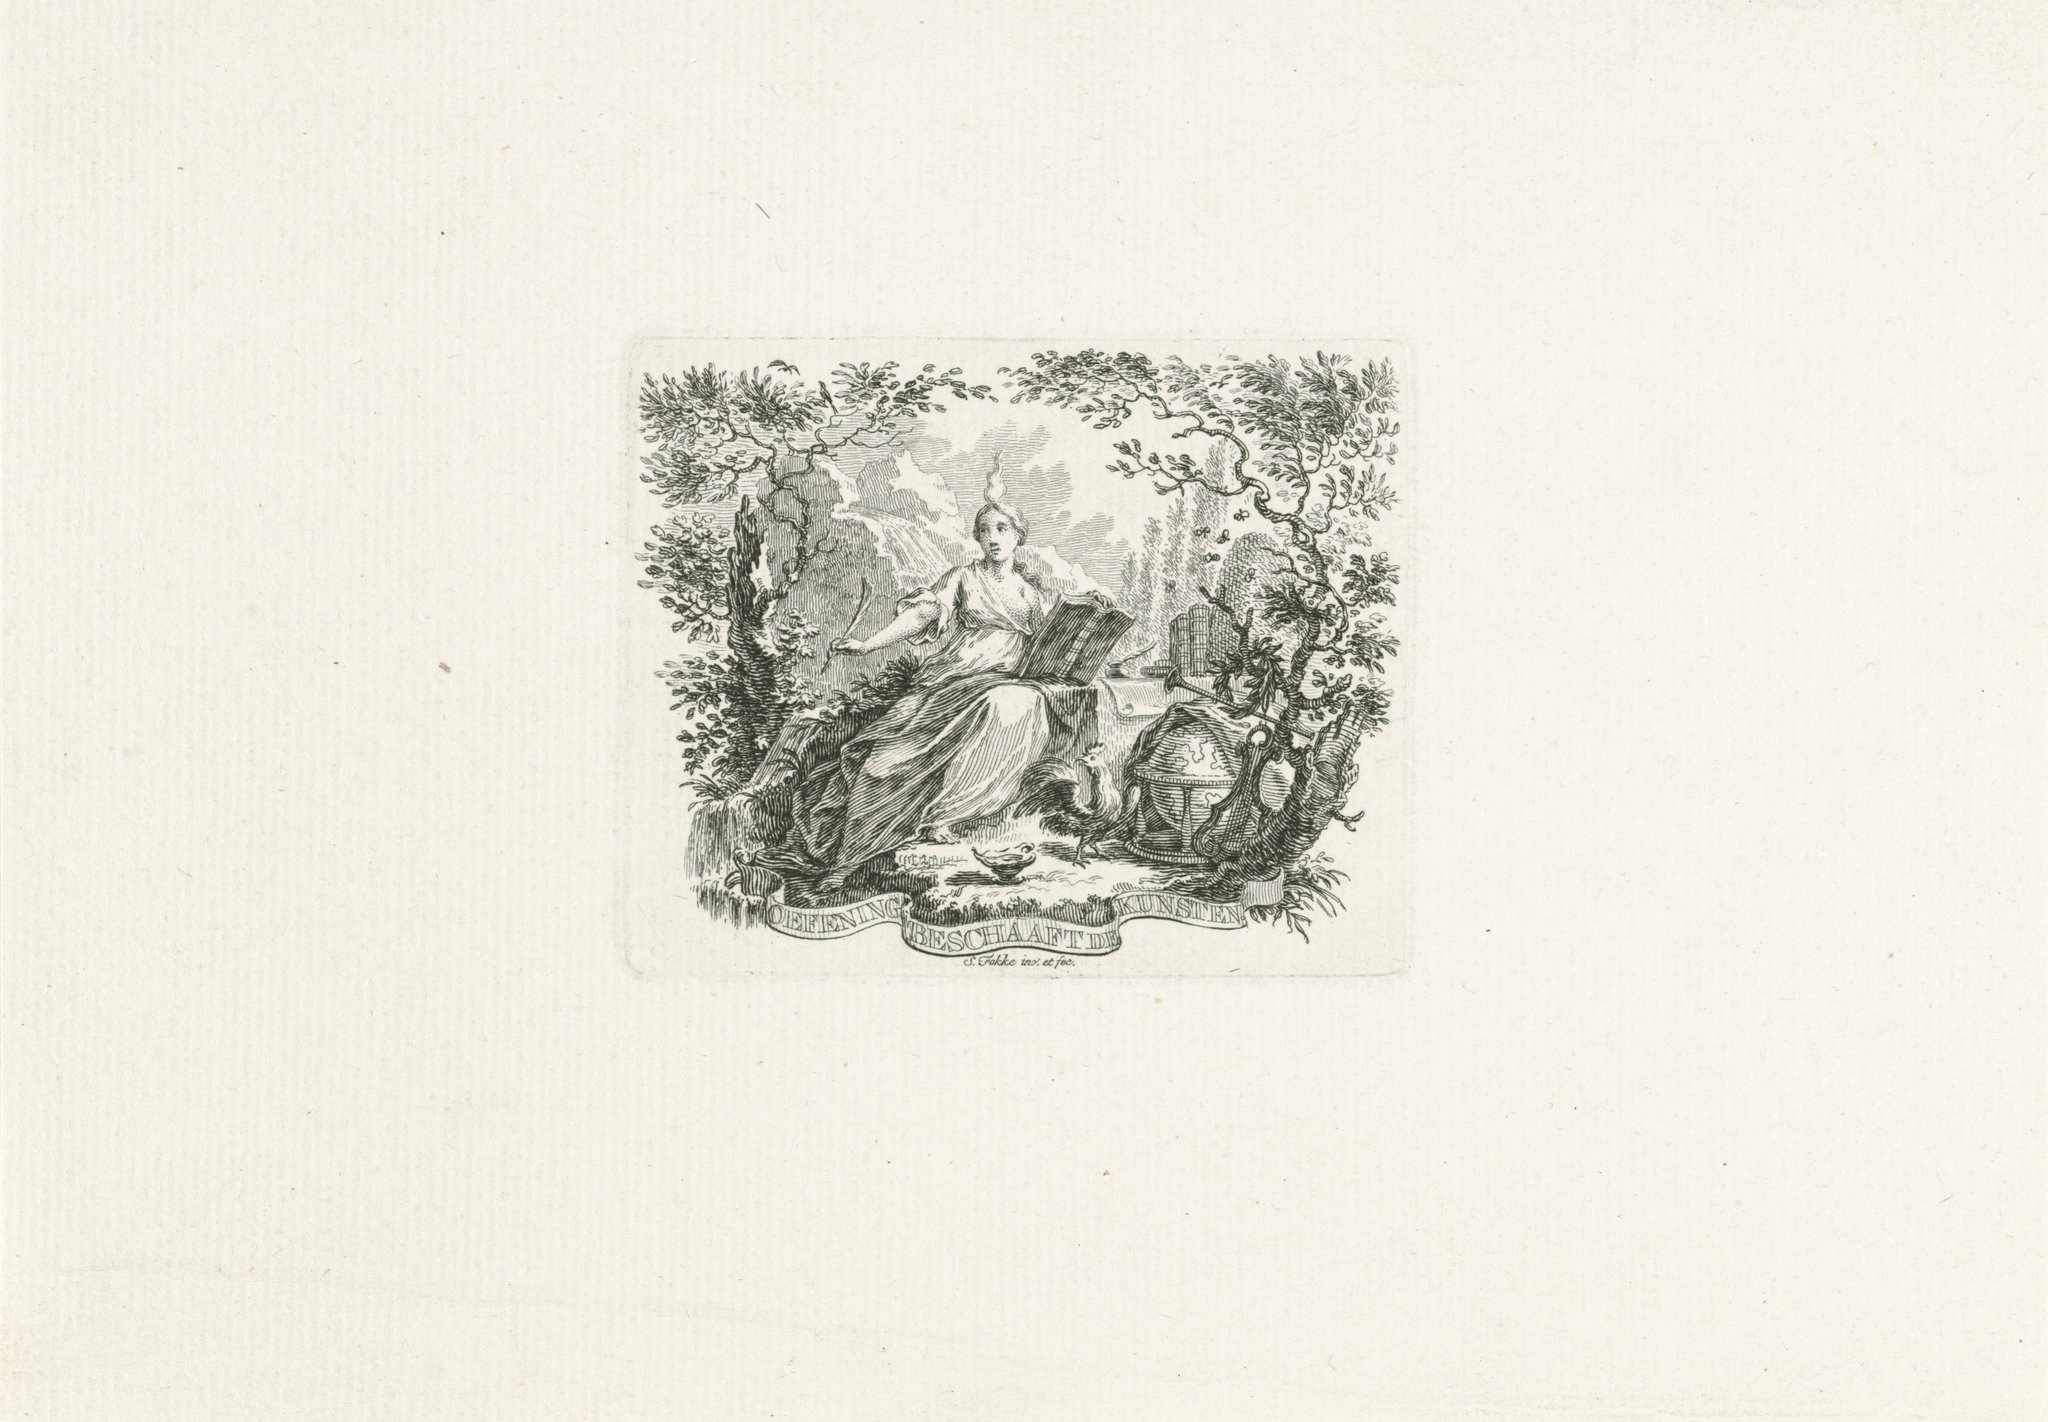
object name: print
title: Vignet van het kunstgenootschap Oefening Beschaaft de Kunsten, ca. 1764-1769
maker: simon fokke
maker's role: draughtsman, print maker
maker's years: 1712-1784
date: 1764-1769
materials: paper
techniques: etching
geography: northern netherlands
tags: symbolic representations, allegories and emblems ~ art; 'arte' (ripa)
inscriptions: collector's mark: Lugt 2228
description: Vignet van het kunstgenootschap Oefening Beschaaft de Kunsten, zoals gebruikt als titelvignet in een uitgave van ca. 1764-1769. Allegorische vrouwenfiguur met pen en boek in de hand en vlam op het hooft.